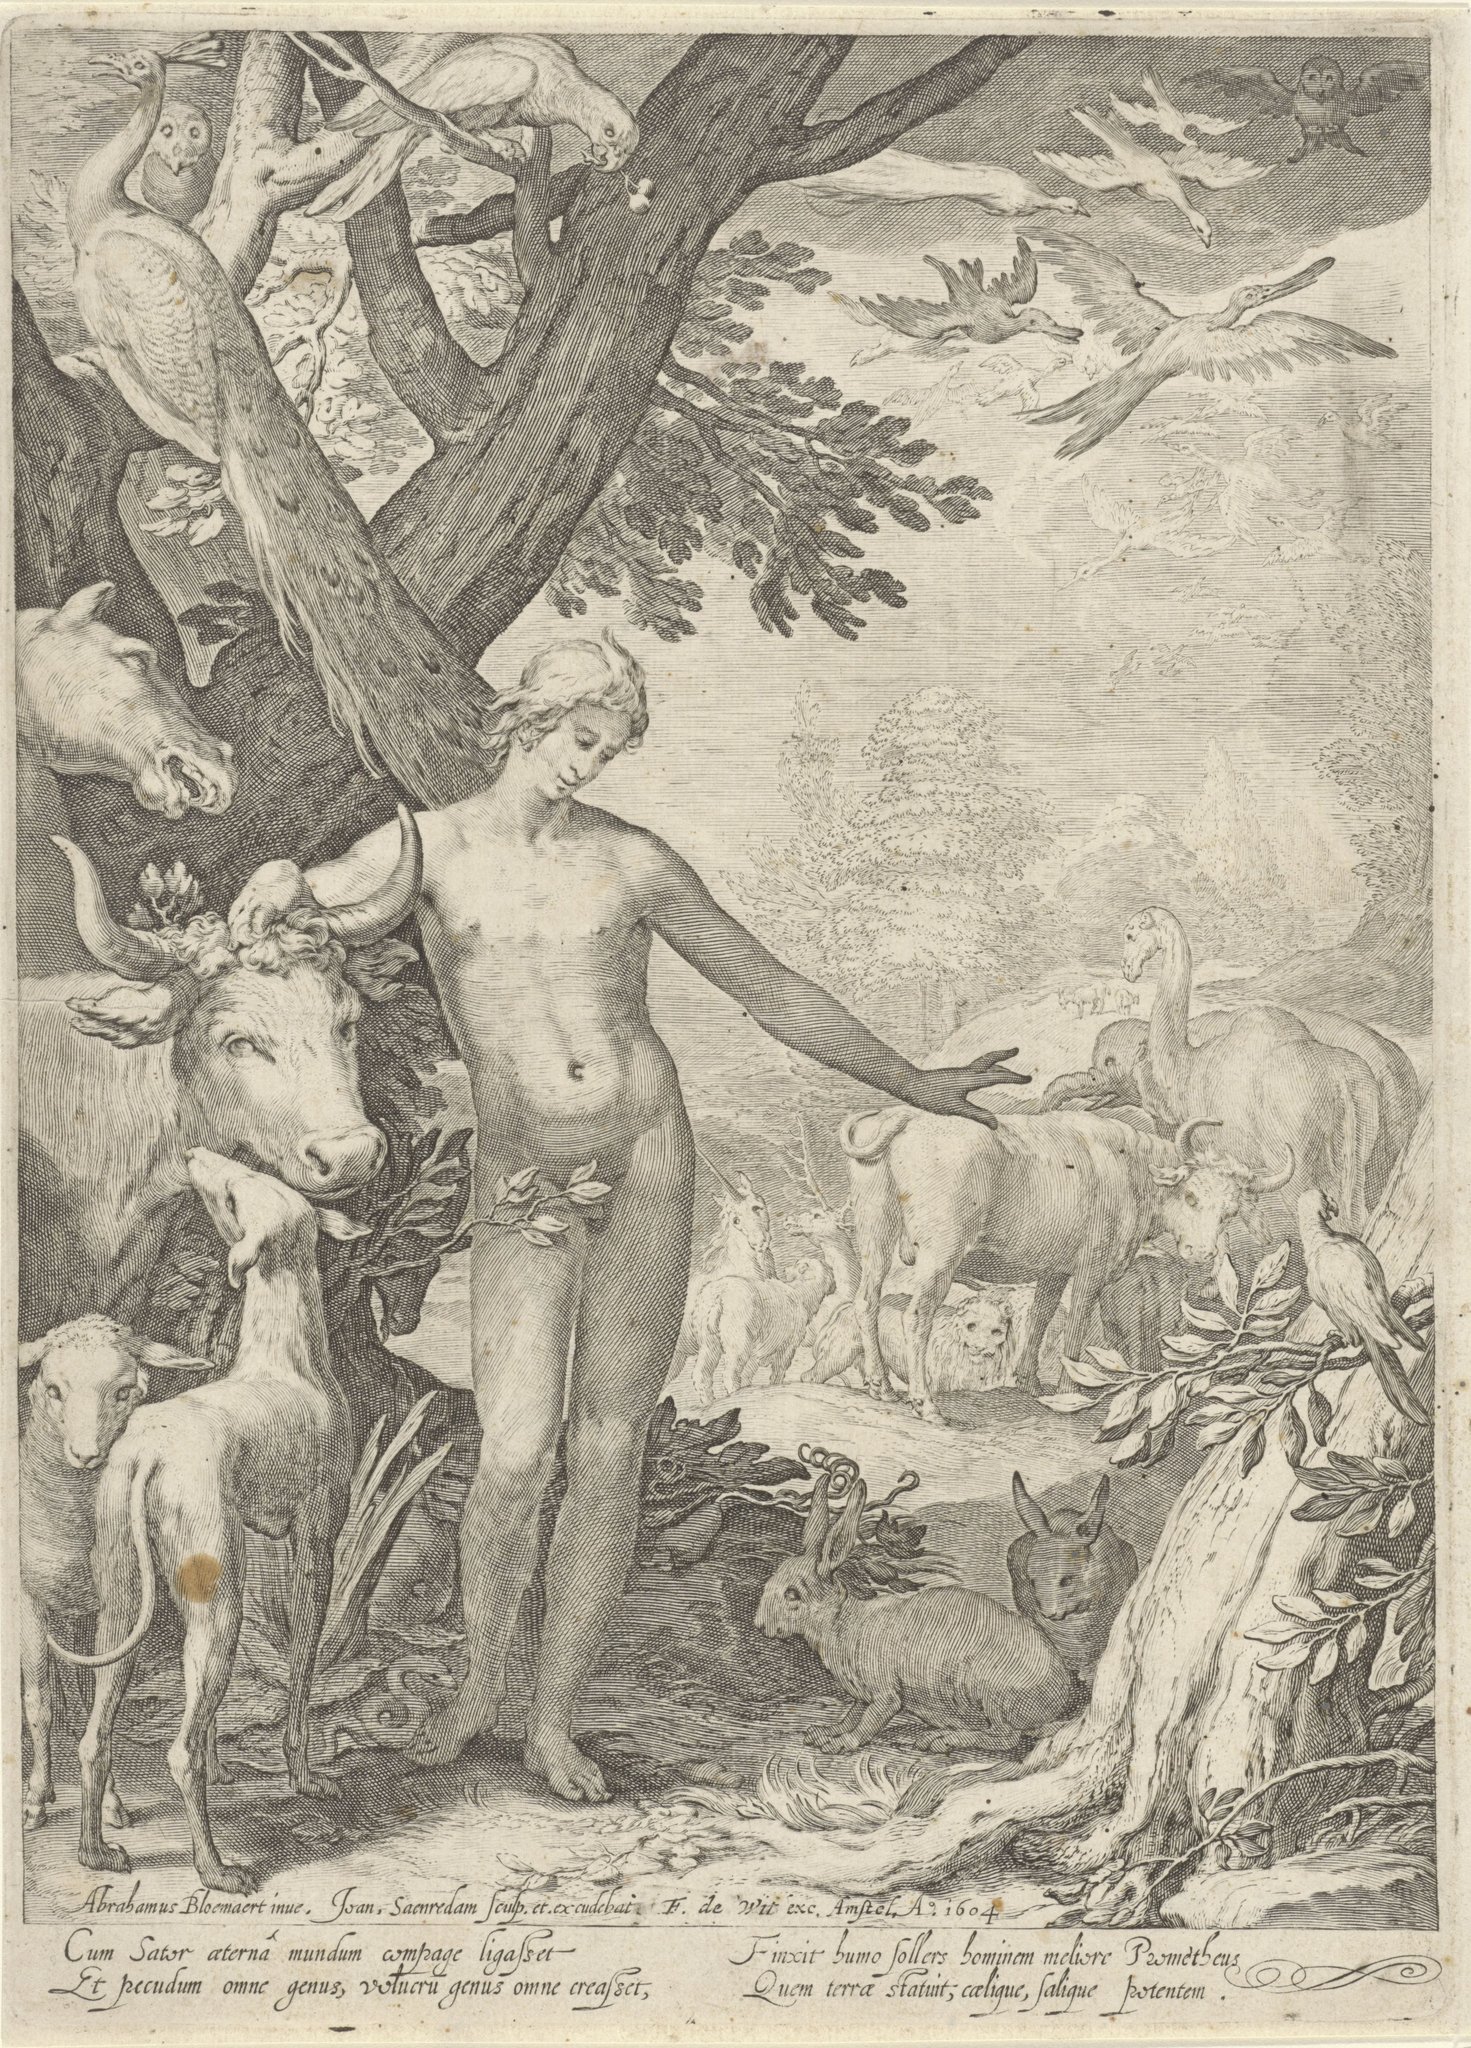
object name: print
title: Adam geeft de dieren namen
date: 1604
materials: paper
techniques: engraving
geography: assendelft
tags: adam naming the animals, unicorn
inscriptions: collector's mark: Lugt 2228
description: Adam staat op de voorgrond. Rondom hem allerlei dieren (stier, hond, schapp, slang, haas, paus, papegaai). Op de achtergrond andere dieren (olifant, leeuw, eenhoorn, kameel) en in de lucht vogels. Adam geeft elk van de dieren een naam. De eerste prent van een zesdelige reeks met als onderwerp het verhaal van Adam en Eva.